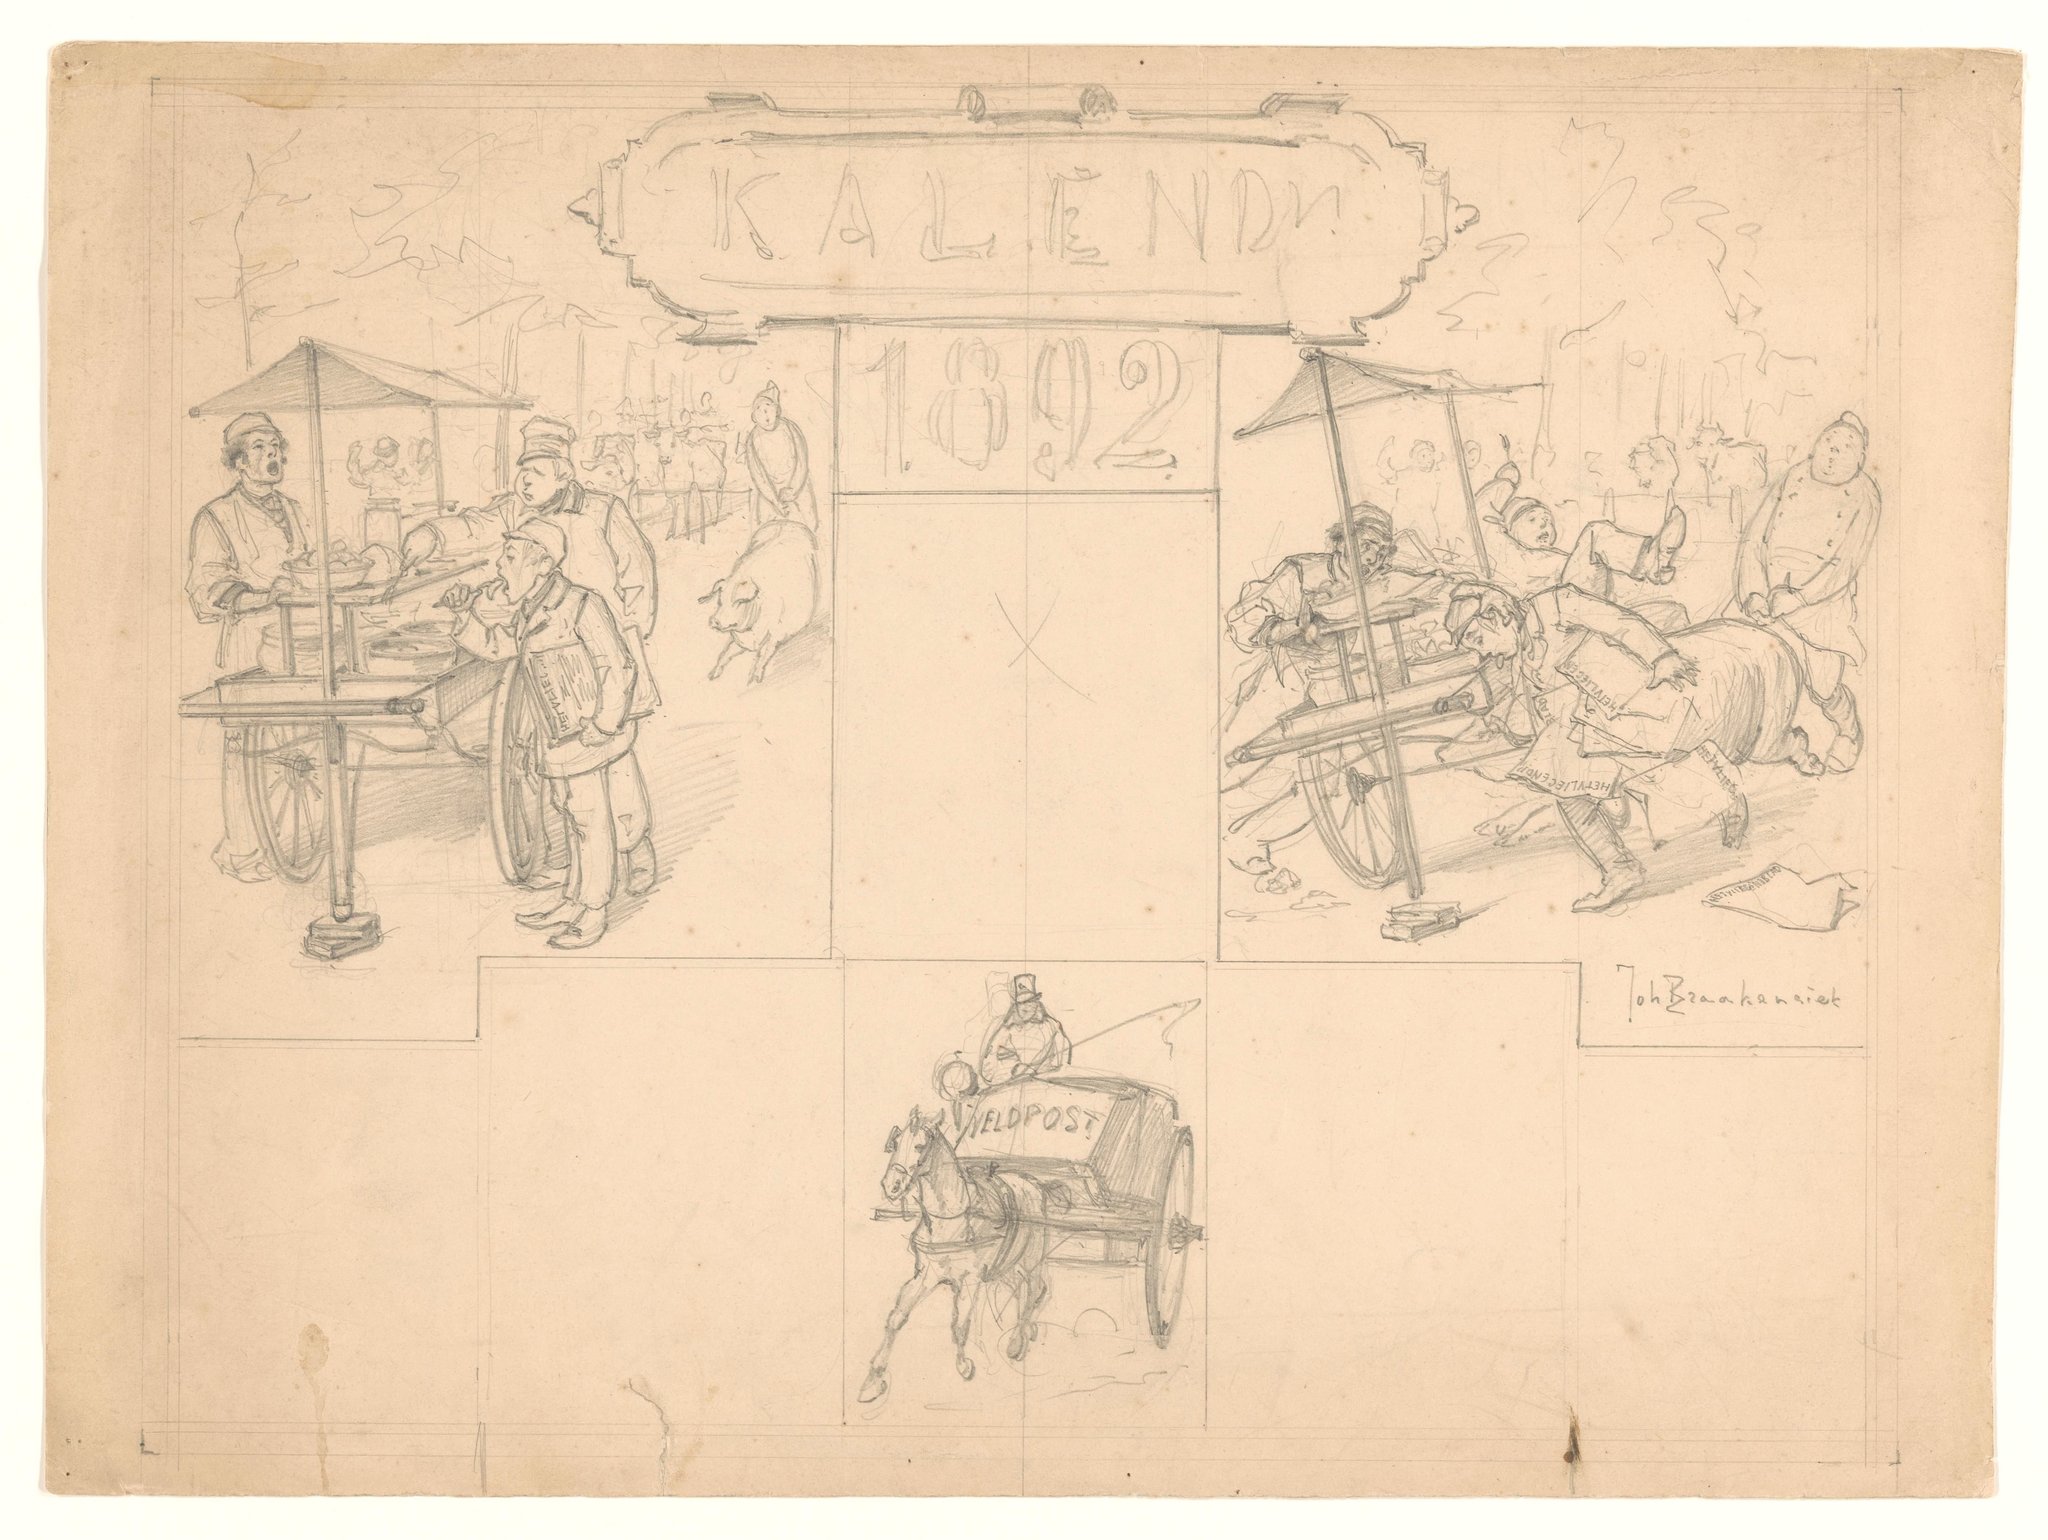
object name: design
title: Ontwerp voor een kalenderblad voor het jaar 1892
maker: johan braakensiek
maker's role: draughtsman, print maker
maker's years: 1858-1940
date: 1868-1940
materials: paper, pencil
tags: historical events and situations